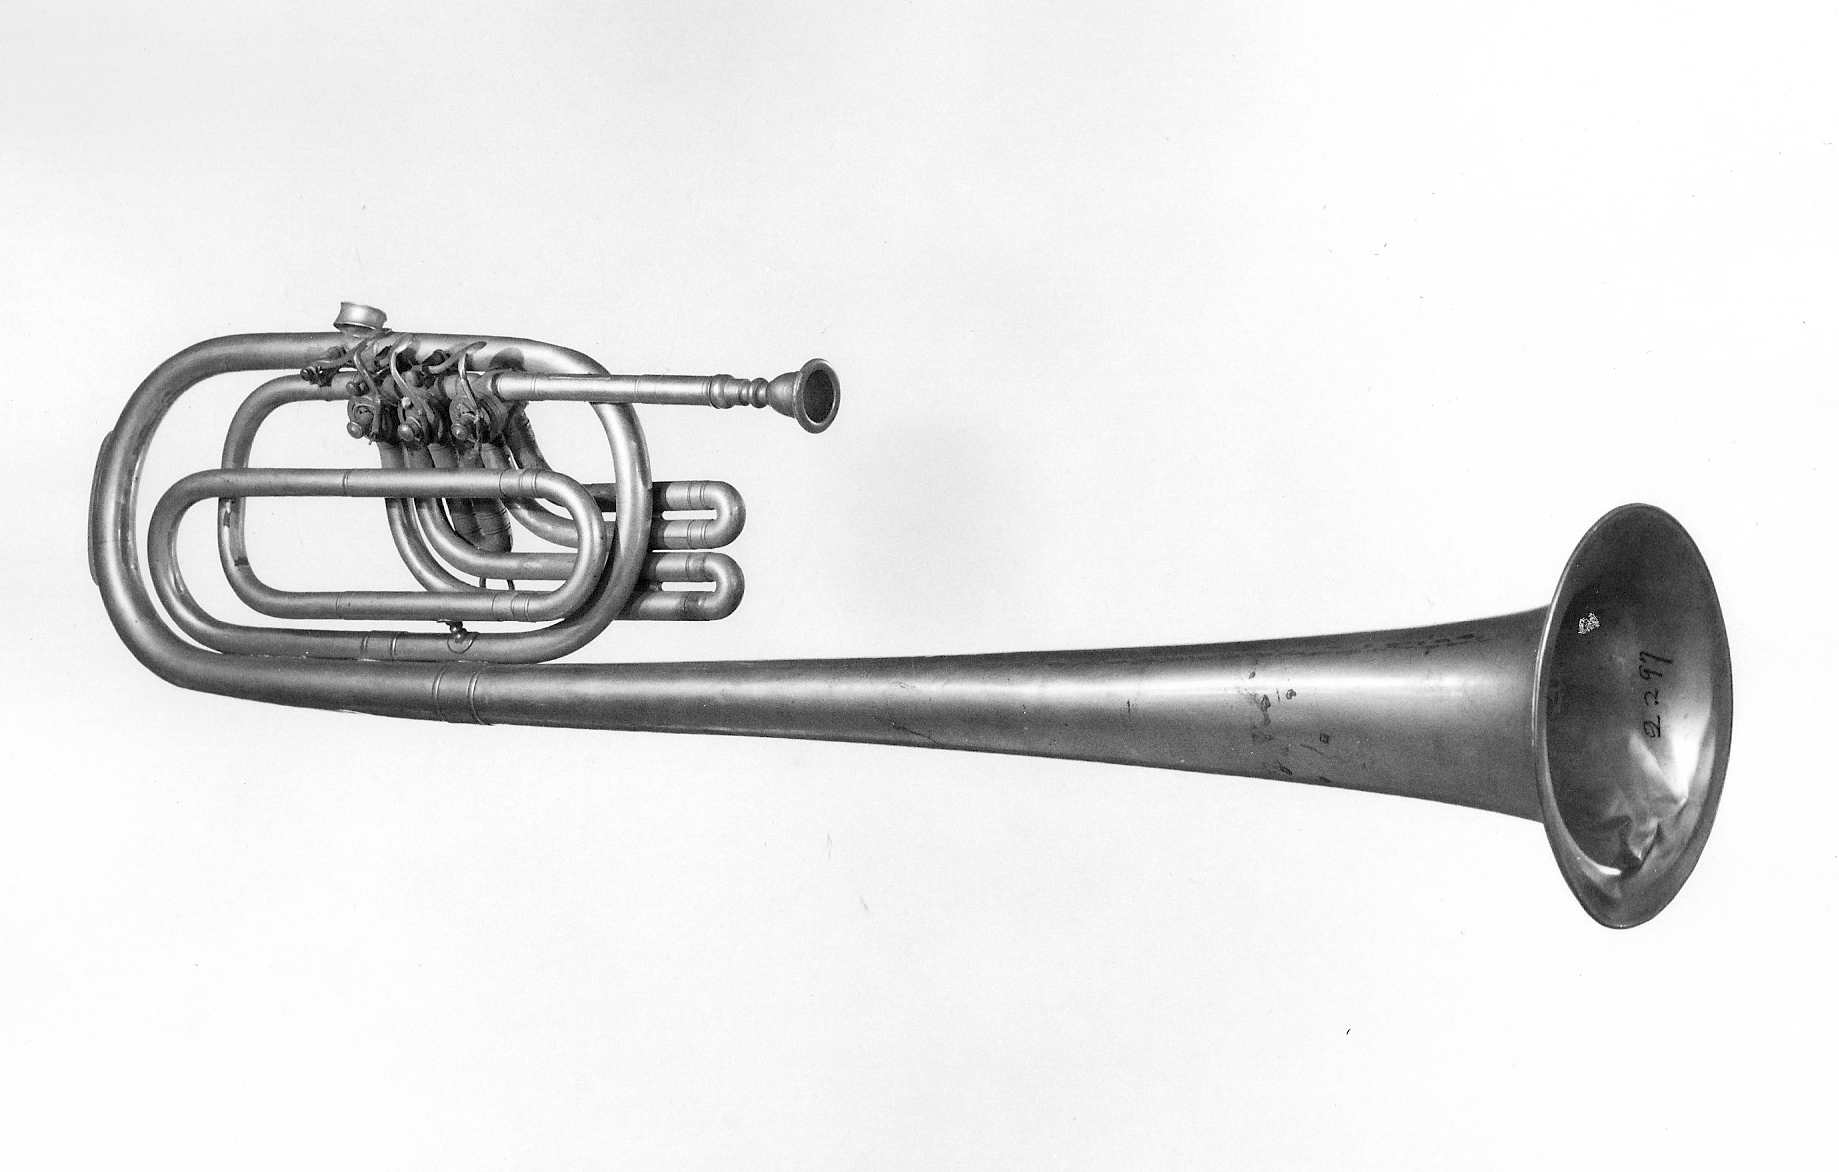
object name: tenor over the shoulder horn in b flat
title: Tenor Over-the-Shoulder Horn in B-flat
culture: american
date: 1834-1866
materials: nickel, silver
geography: united states